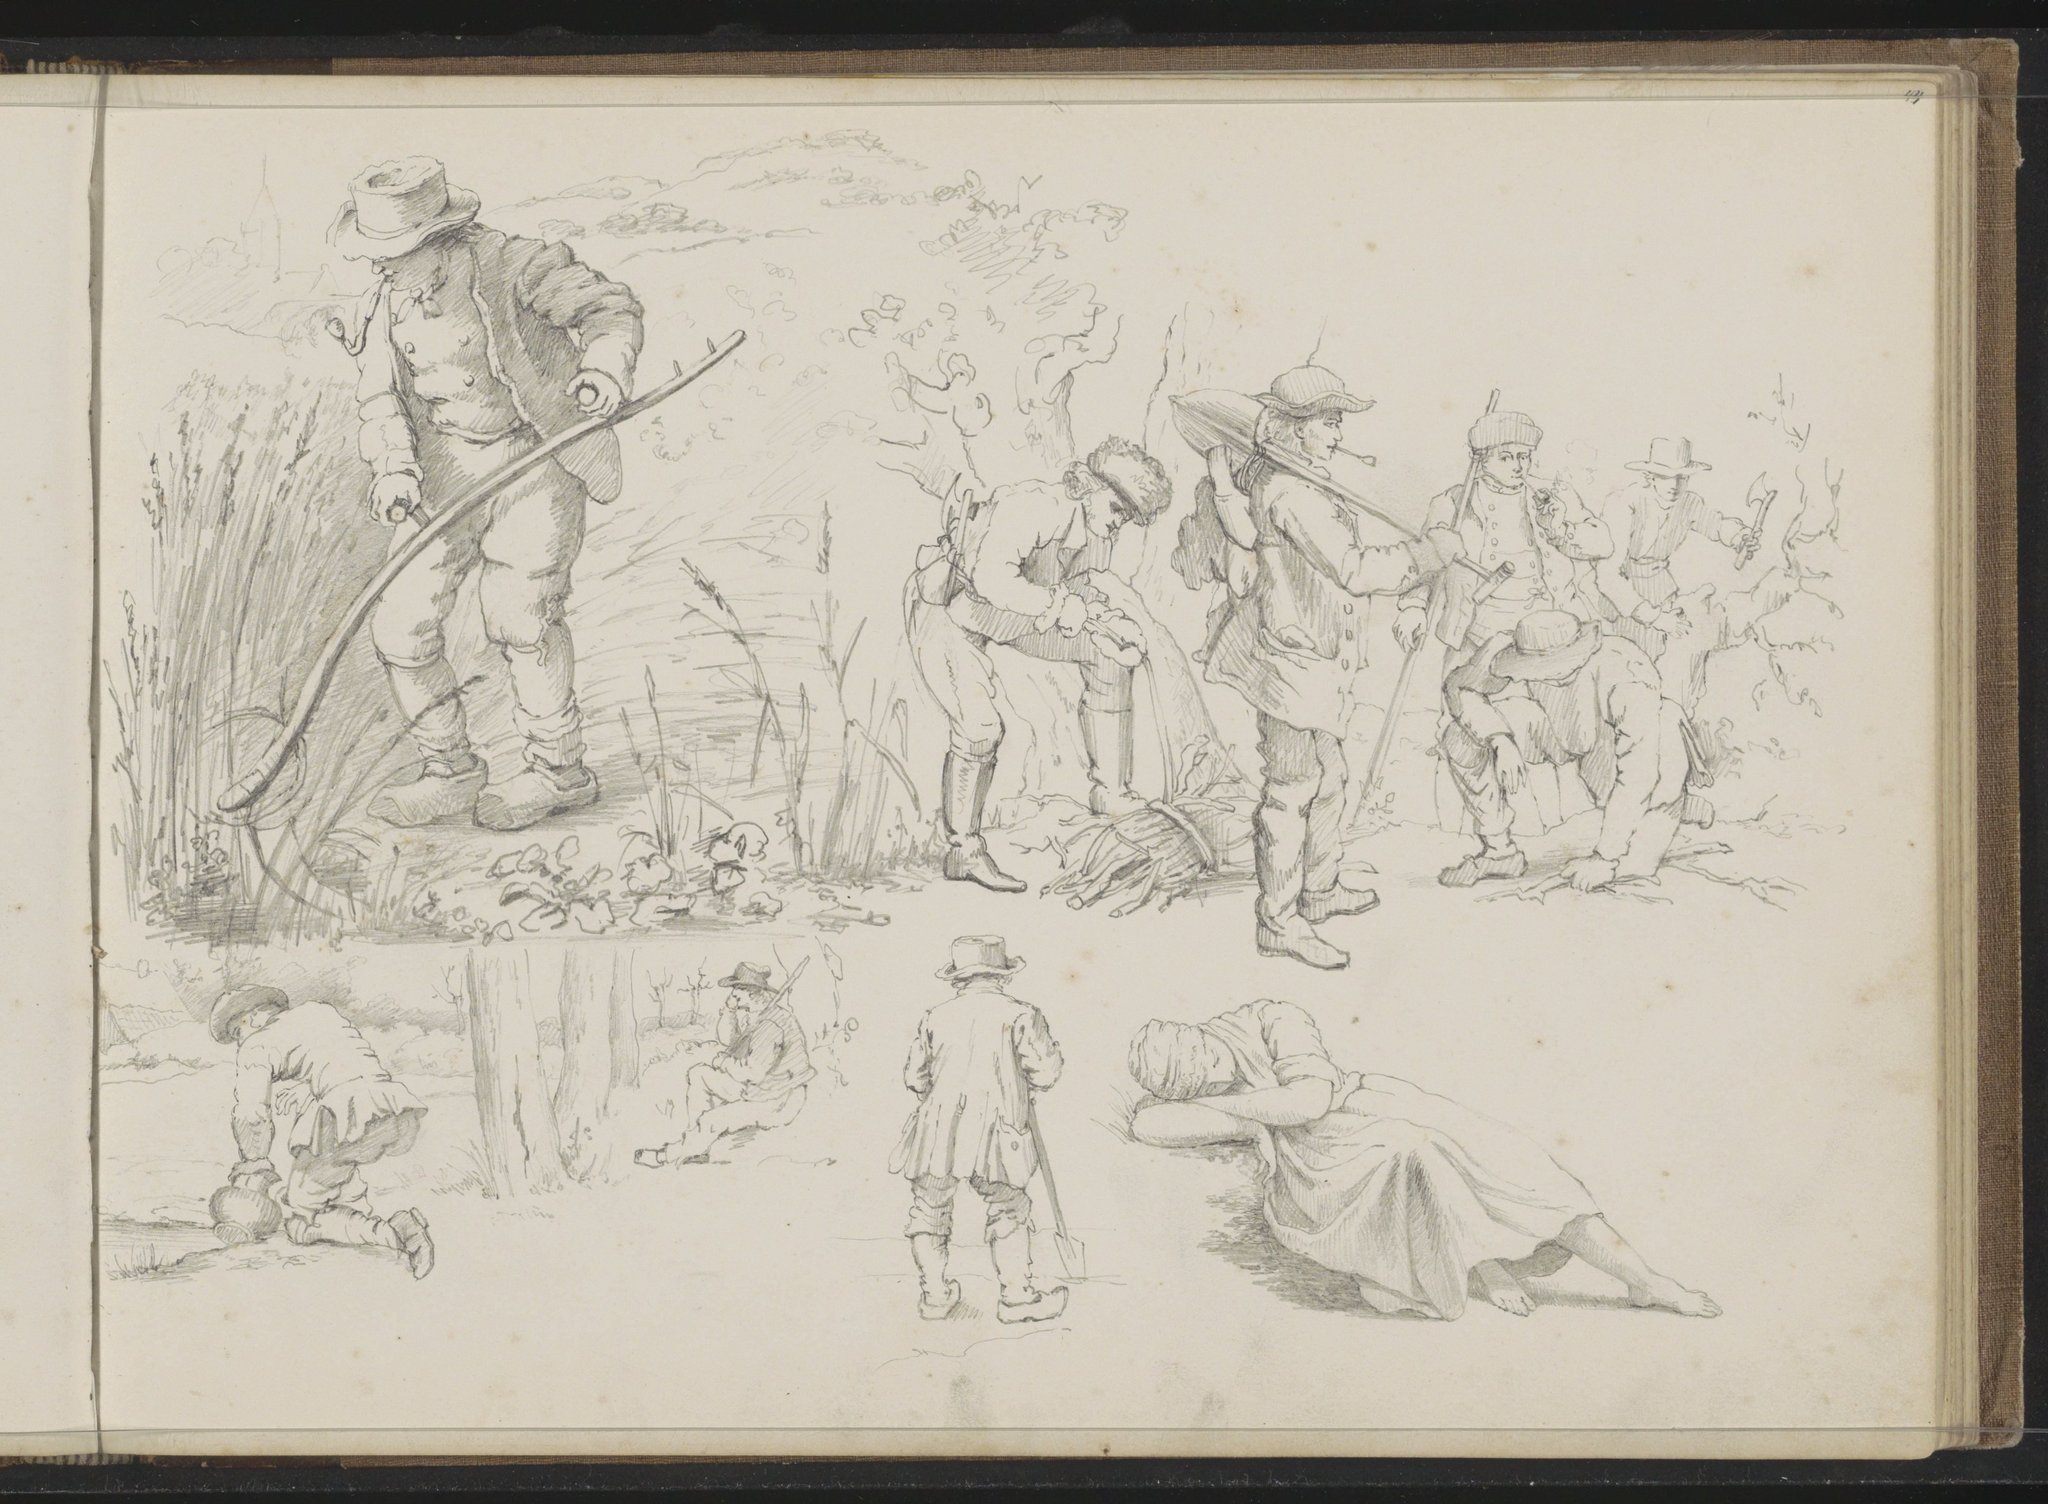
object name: sketchbook leaf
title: Studieblad met mannen met werktuigen in de natuur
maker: hendrik valkenburg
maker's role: draughtsman, painter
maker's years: 1826-1896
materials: paper, pencil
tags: tools, aids, implements ~ crafts and industries, sleeping; unconsciousness - bb - out of doors, container of textile material: bag, sack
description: Onder andere studies van een maaiende boer en mannen met een schop en een bos sprokkelhout. Tevens studies van een man die een kruik vult aan een waterkant en van een slapende vrouw in de open lucht. Blad 44 recto uit een schetsboek met 77 bladen.